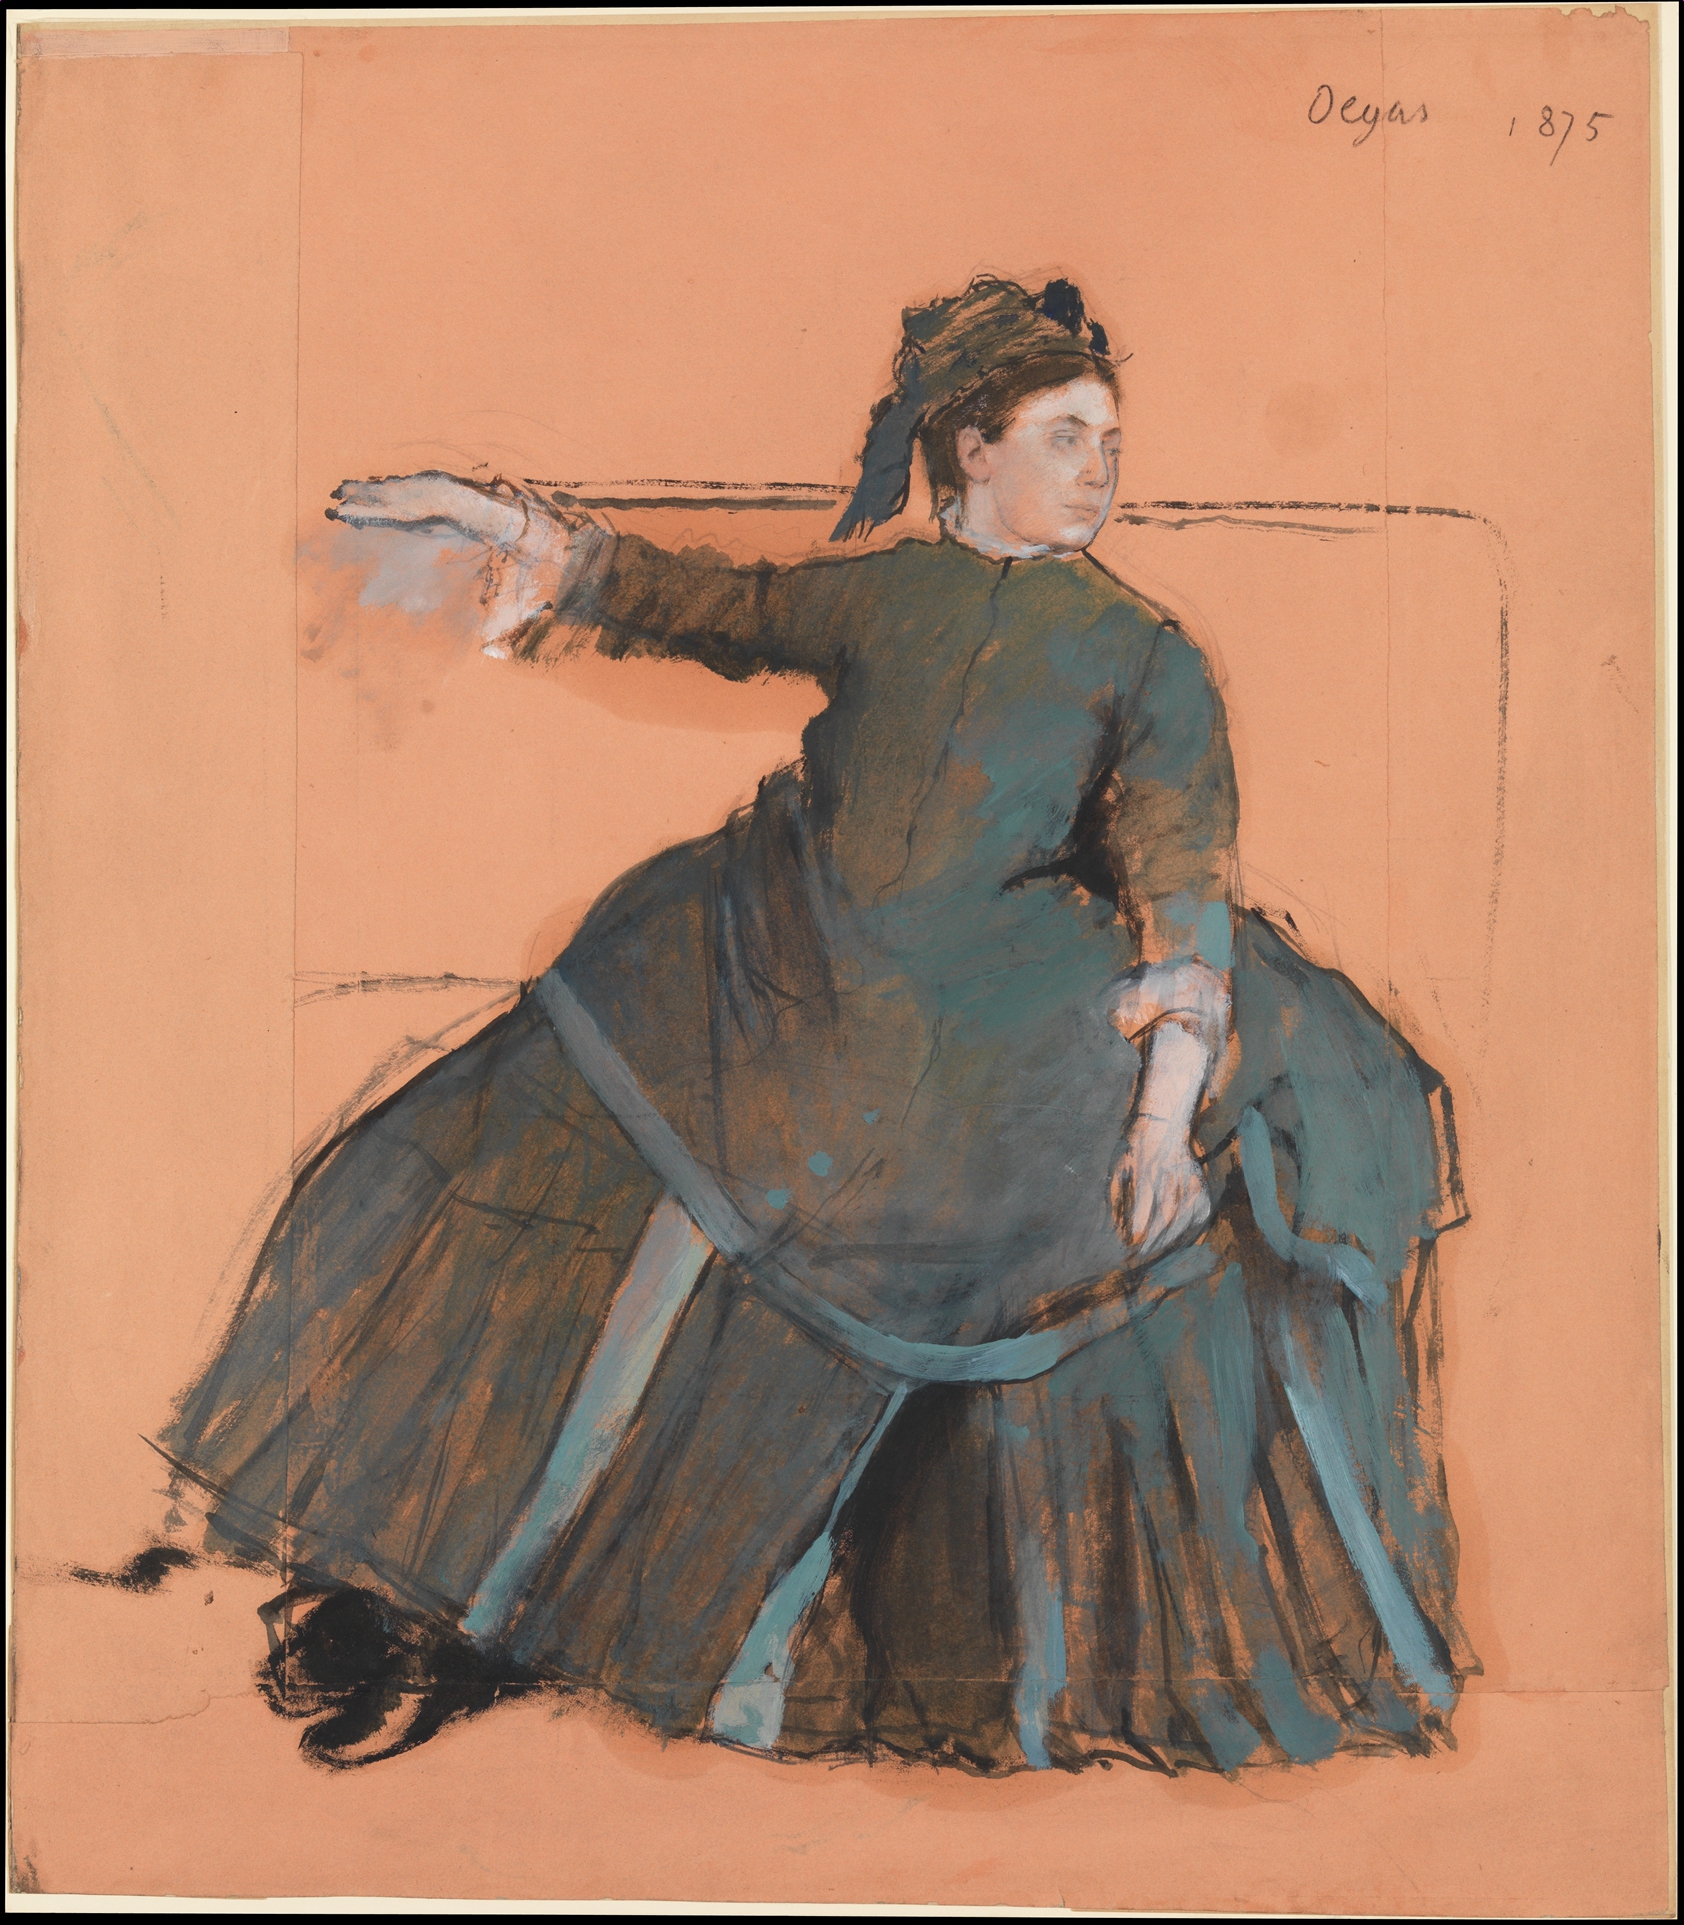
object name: drawing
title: Woman on a Sofa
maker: edgar degas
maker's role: artist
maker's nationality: french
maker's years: 1834-1917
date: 1875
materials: graphite, oil, paper, pastel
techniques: drawing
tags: women